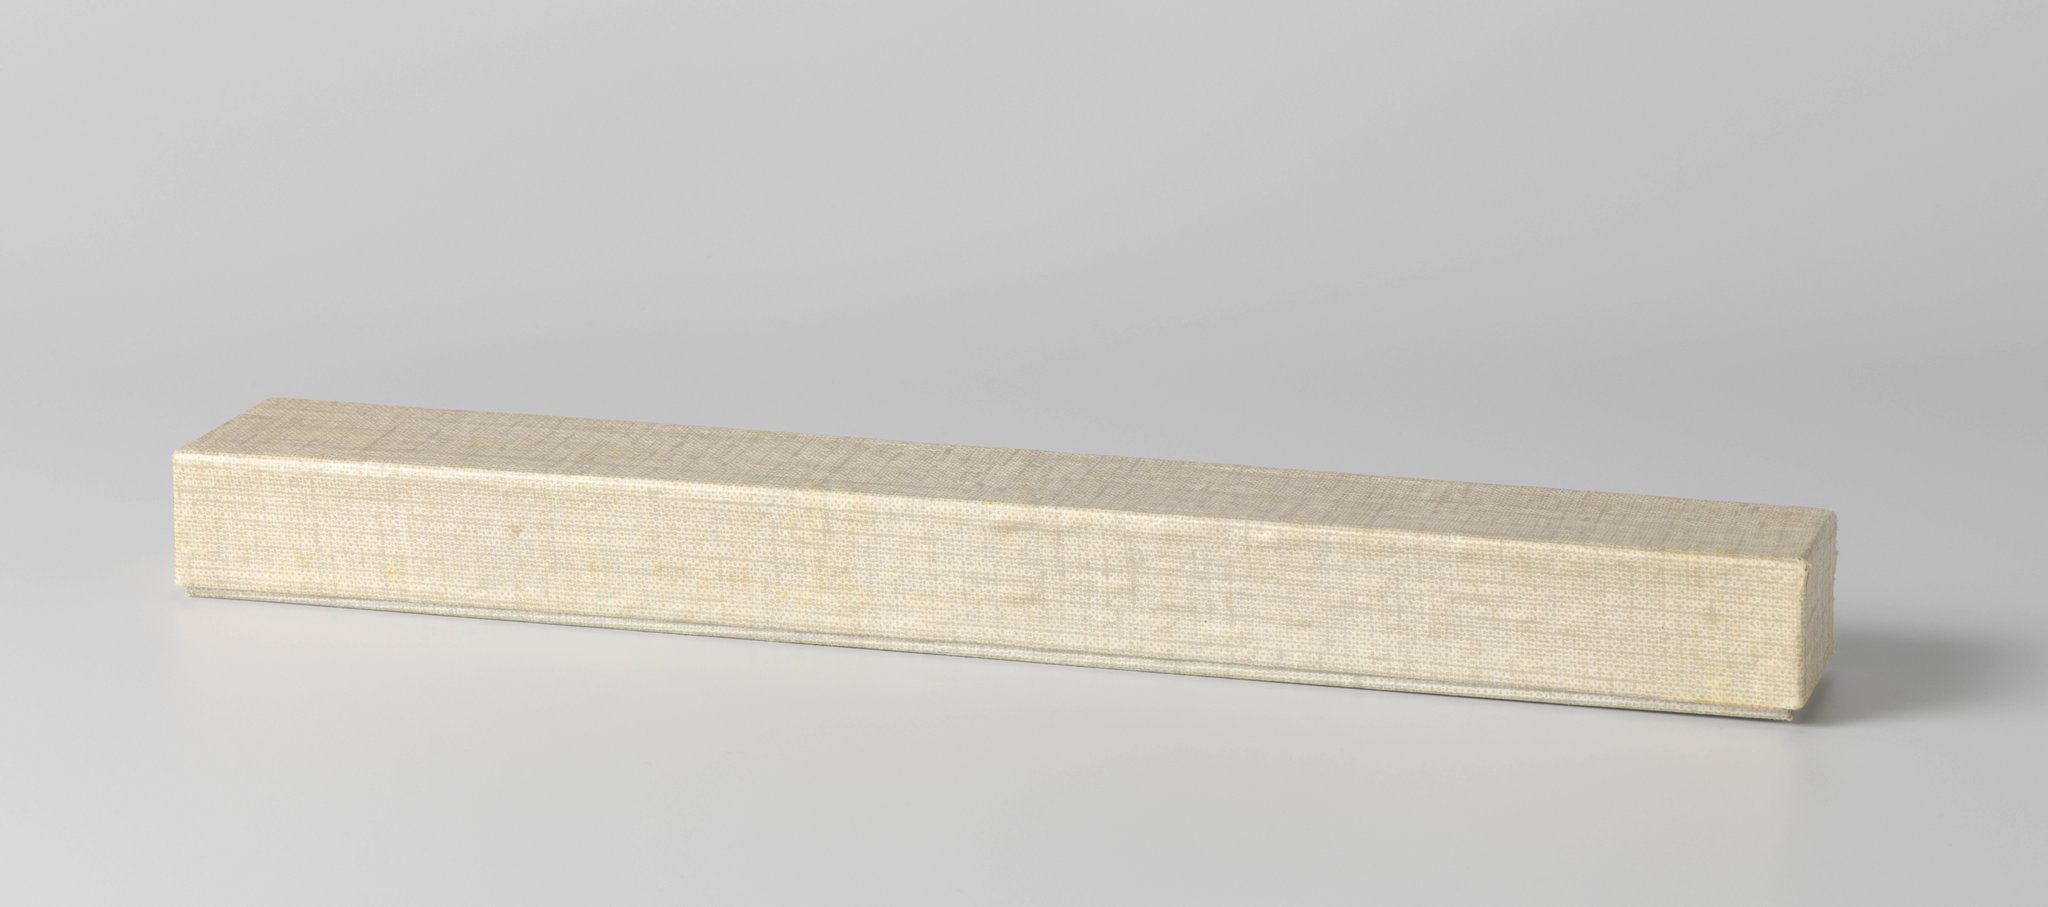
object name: waaierdoos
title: Waaierdoos van karton beplakt met grijs/beige papier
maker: Anonymous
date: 1950-1970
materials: cardboard, paper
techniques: pasting, scooping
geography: netherlands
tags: amsterdam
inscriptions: inscription: ‘C.I. Six, souvenir F[reu]le Louk Blaauw-Six/ L.D.C. Six 1862-1934’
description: Smalle, langwerpige doos voor waaier. Wit karton beplakt met papier met grijze en beige strepen en punten.